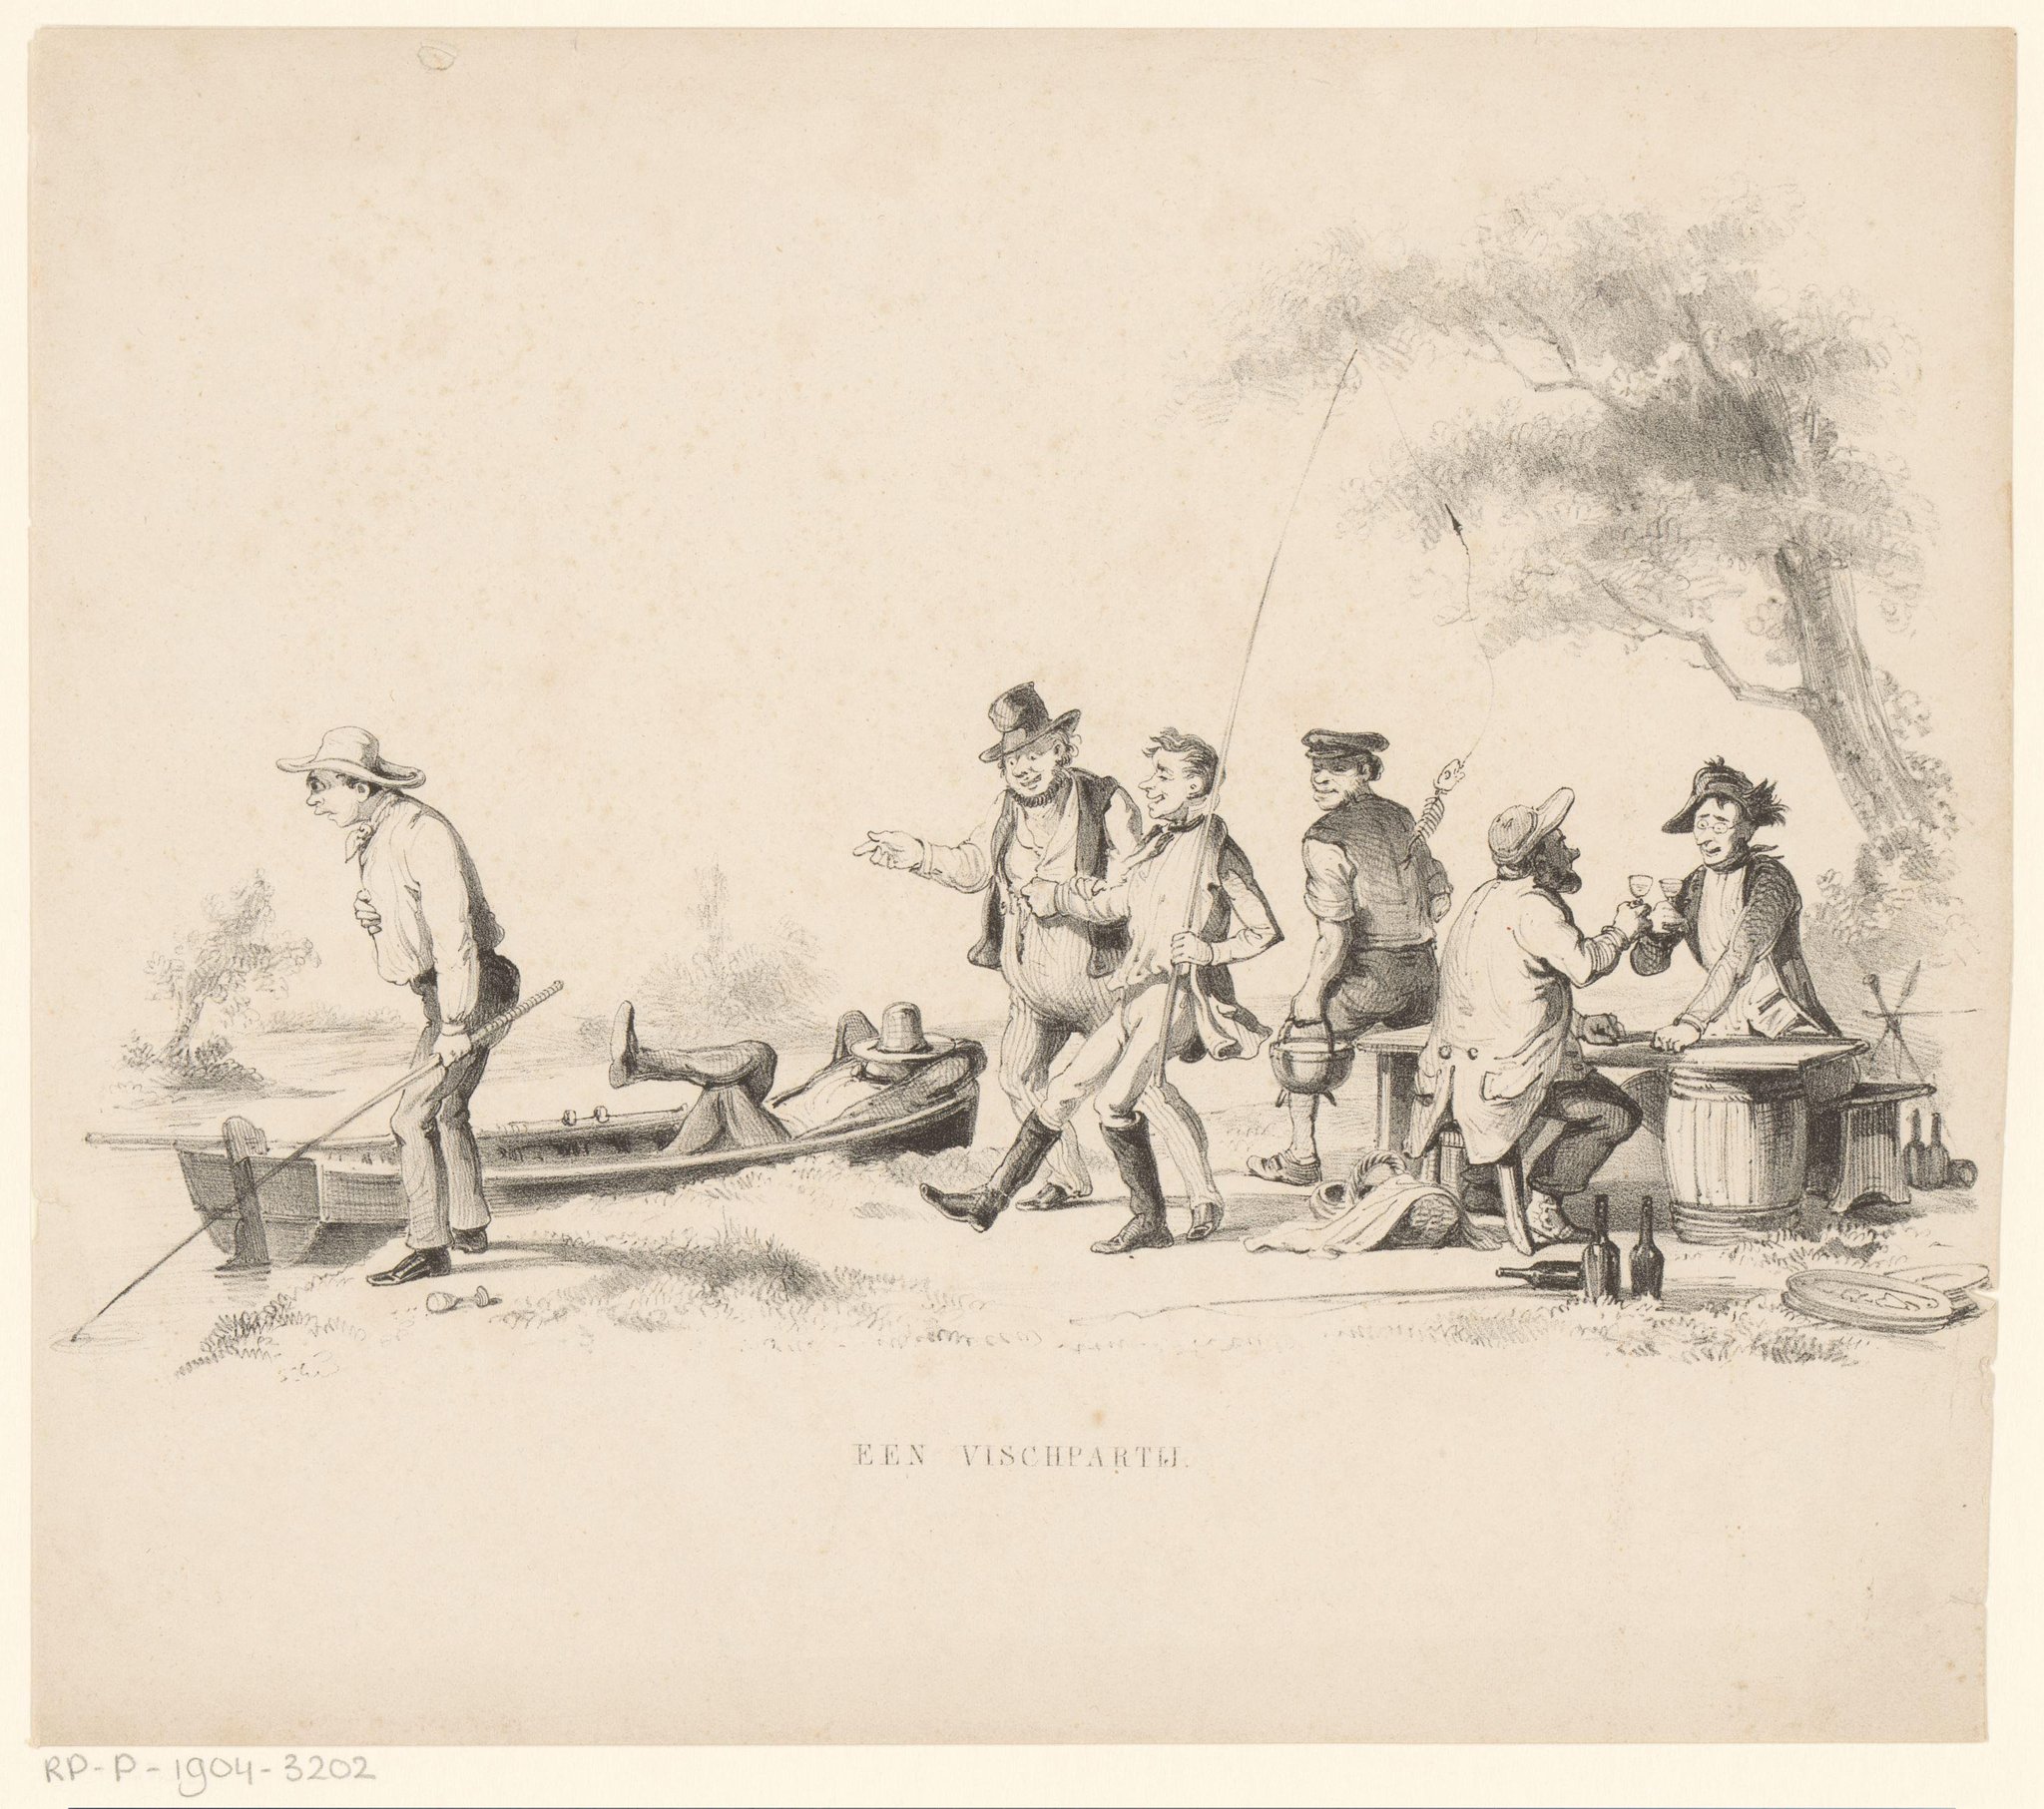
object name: print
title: Vissers en drinkende mannen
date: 1832-1897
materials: paper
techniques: lithograph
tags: fishing (sports), sleeping; unconsciousness, drinking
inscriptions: collector's mark: Lugt 2228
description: Links staat een visser op de oever en ligt een man te slapen in een boot. Twee vissers komen aanlopen. Achter hen zitten twee drinkende mannen aan tafel en loopt een man met een ketel.